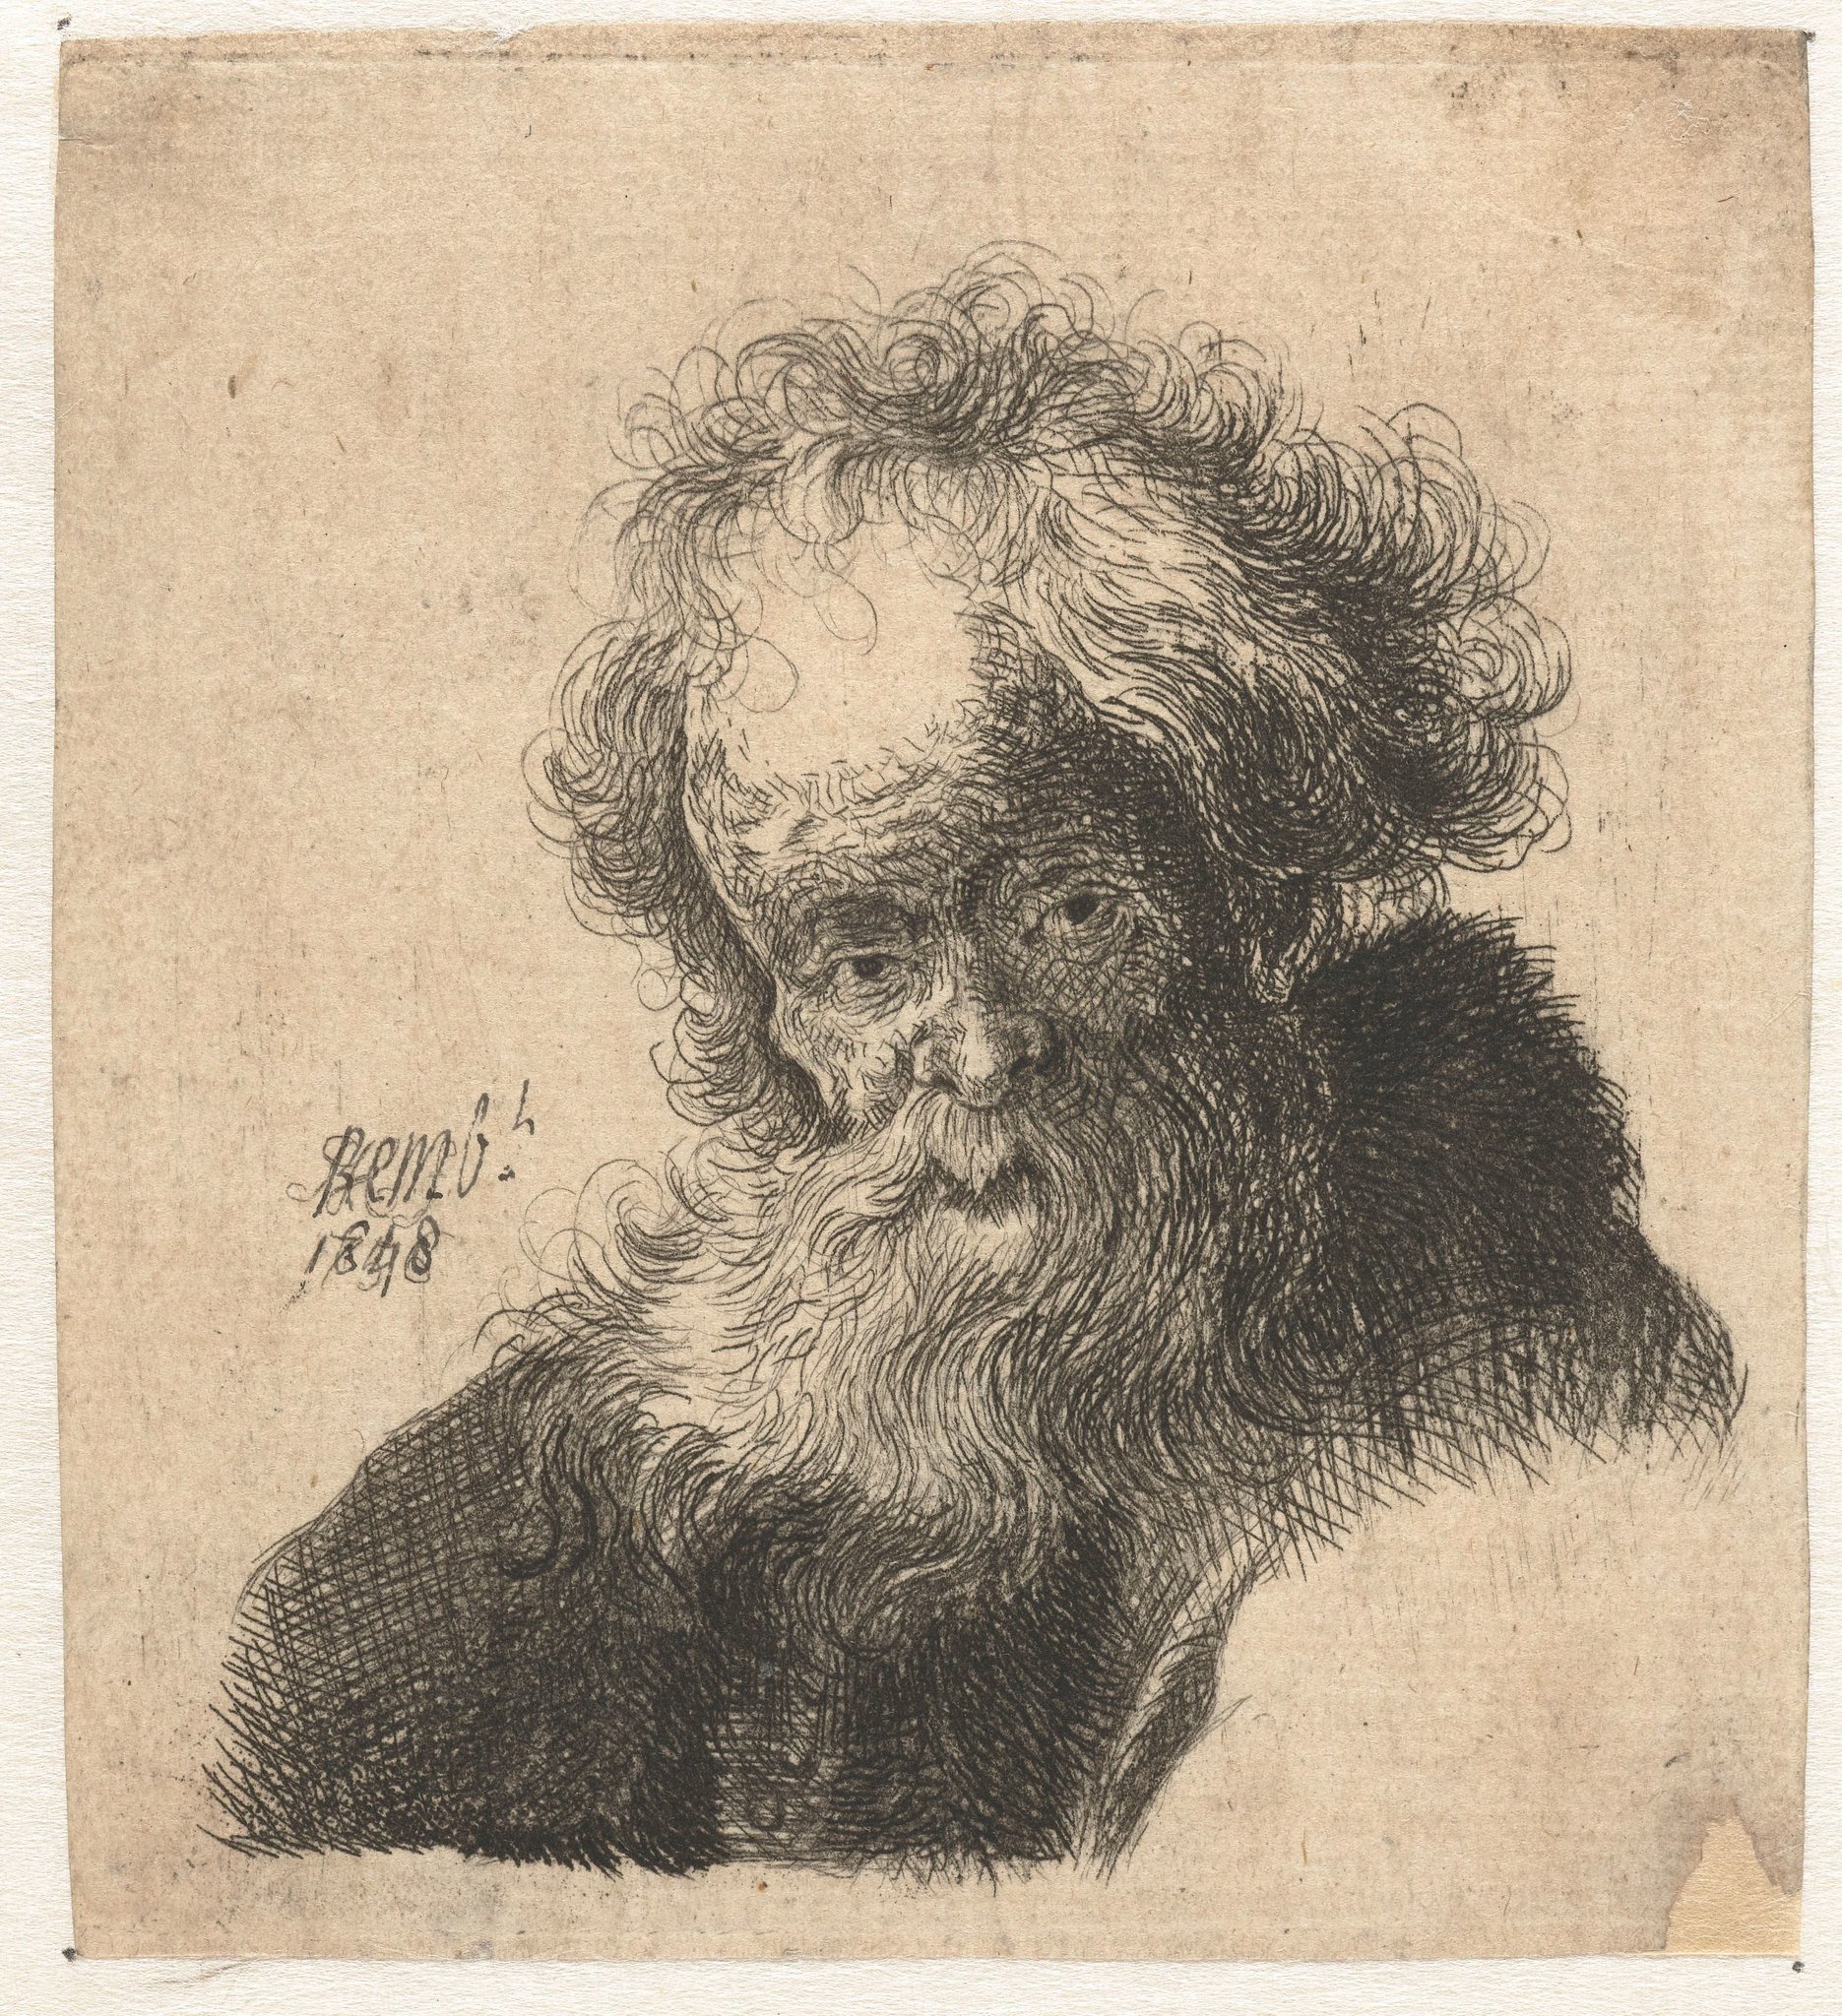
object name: print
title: Bust of an old man with flowing beard and white sleeve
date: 1848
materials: paper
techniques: etching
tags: old man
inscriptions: signature: ‘Remb. 1848’, collector's mark: Lugt 2228, collector's mark: Lugt 2760